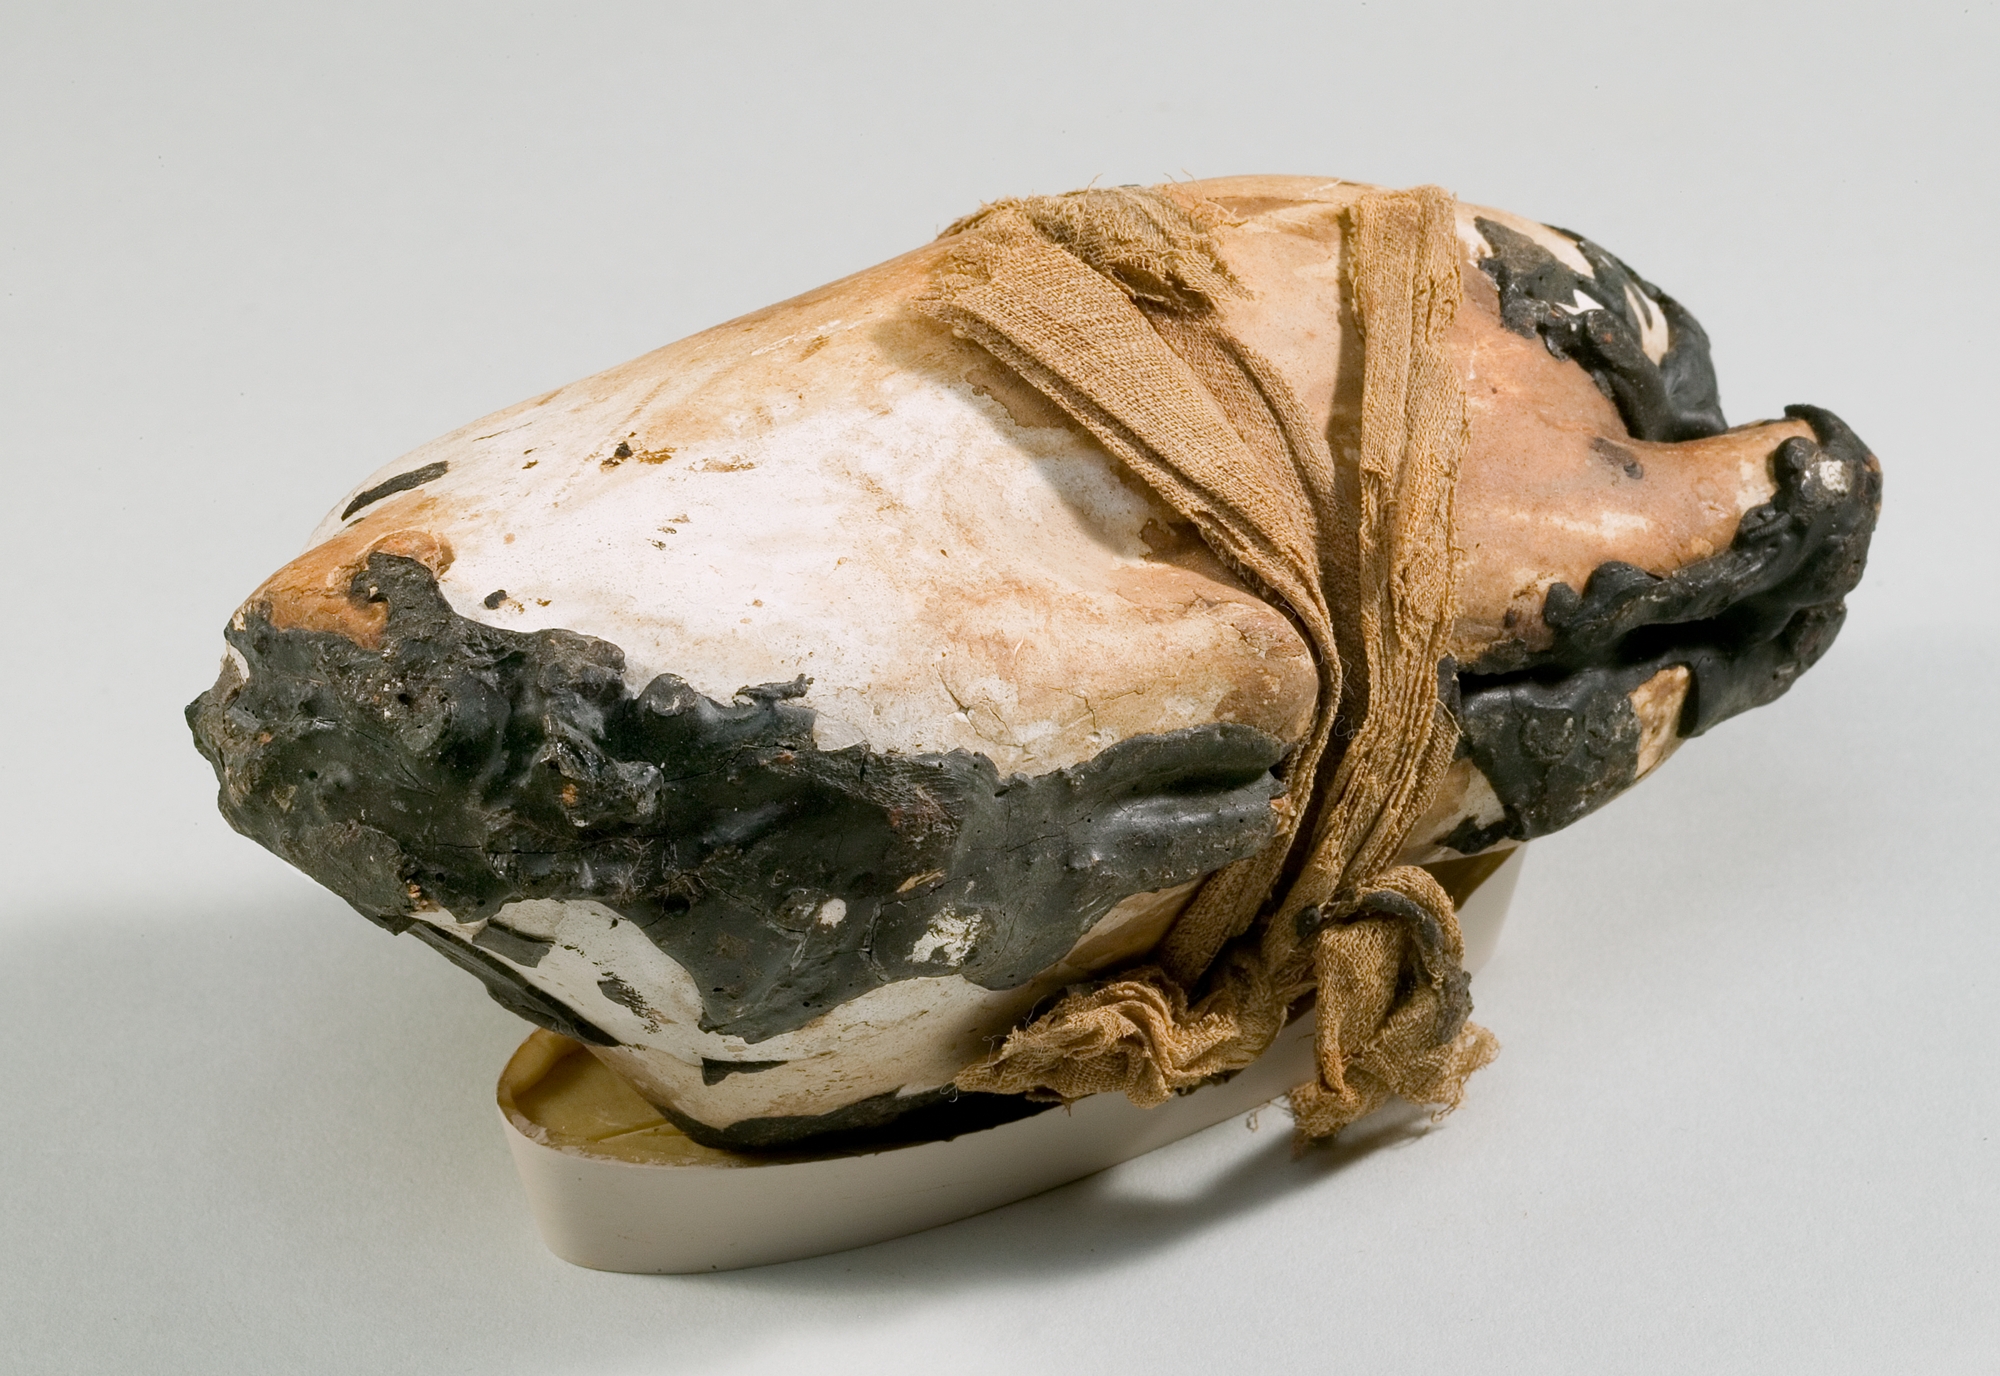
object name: food, case, bird, pigeon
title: Food Case Probably Containing a Preserved Pigeon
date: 1550-1479 BCE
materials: linen, plaster, wood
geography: egypt